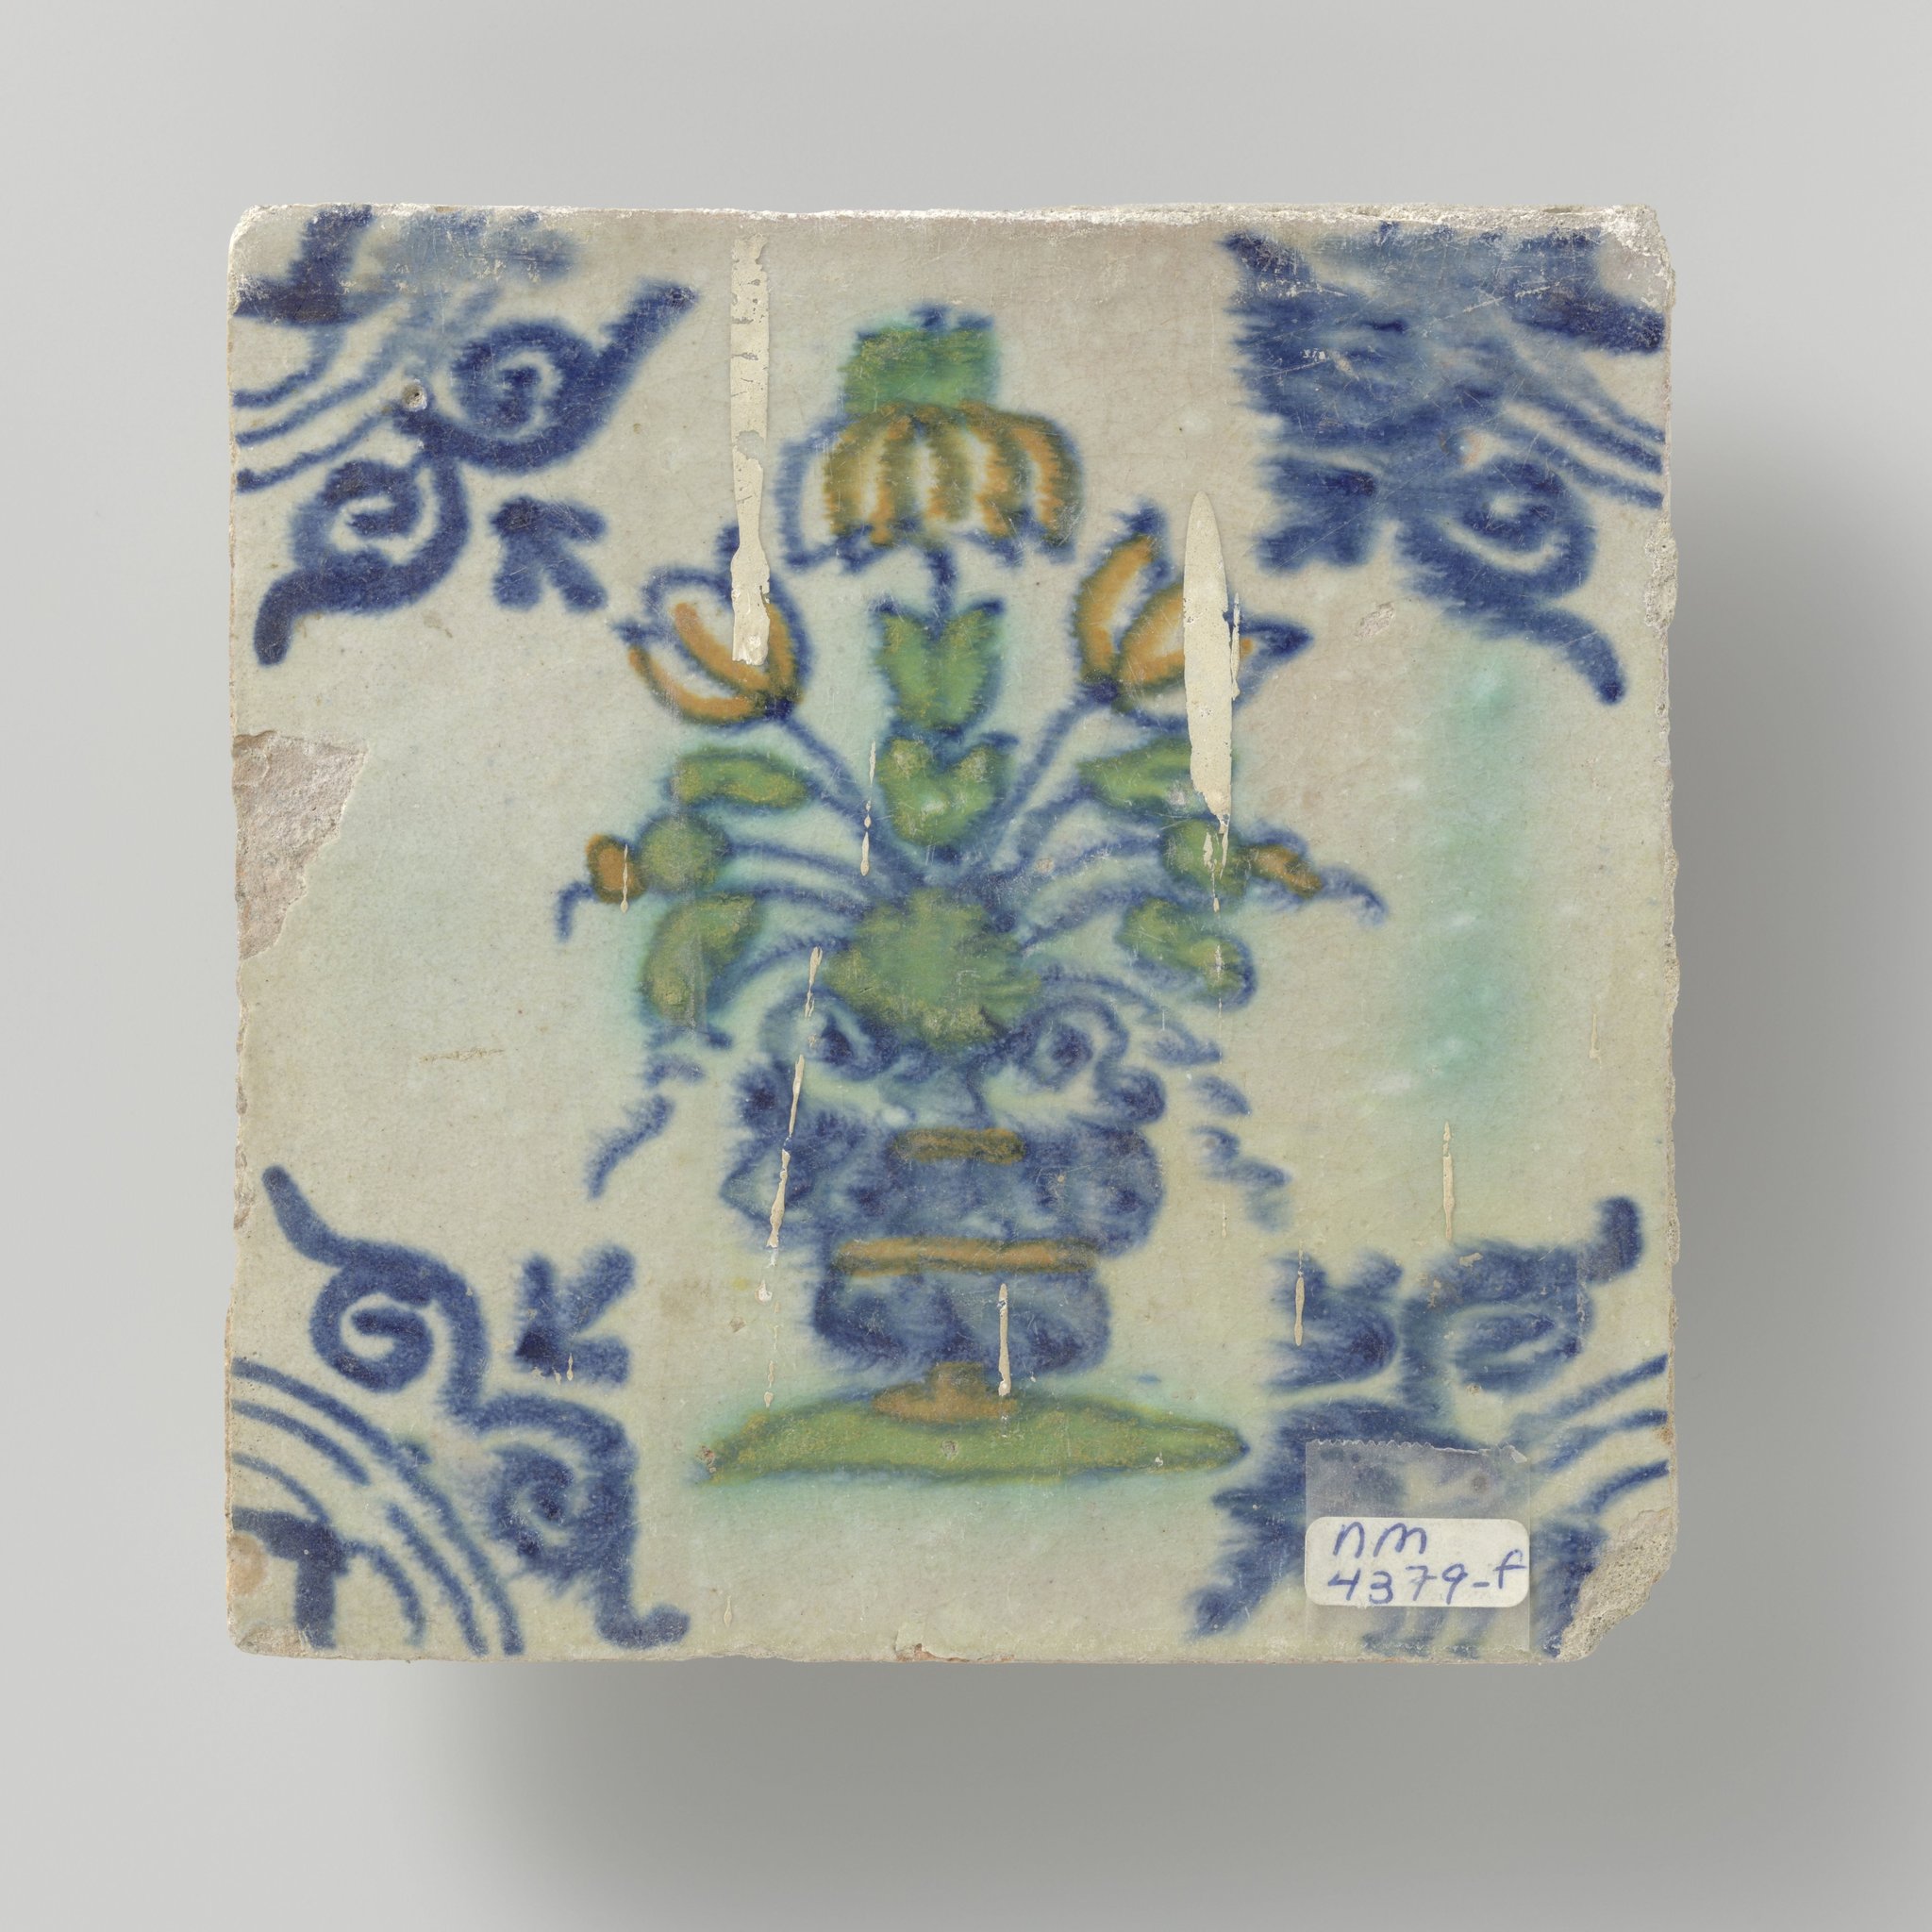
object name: tile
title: Tegel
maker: Anonymous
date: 1640-1660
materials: earthenware, glaze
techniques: maiolica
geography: netherlands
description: Tegel met een veelkleurige (blauw, groen, oranje en geel) bloempot. In de hoeken, een ossekop.